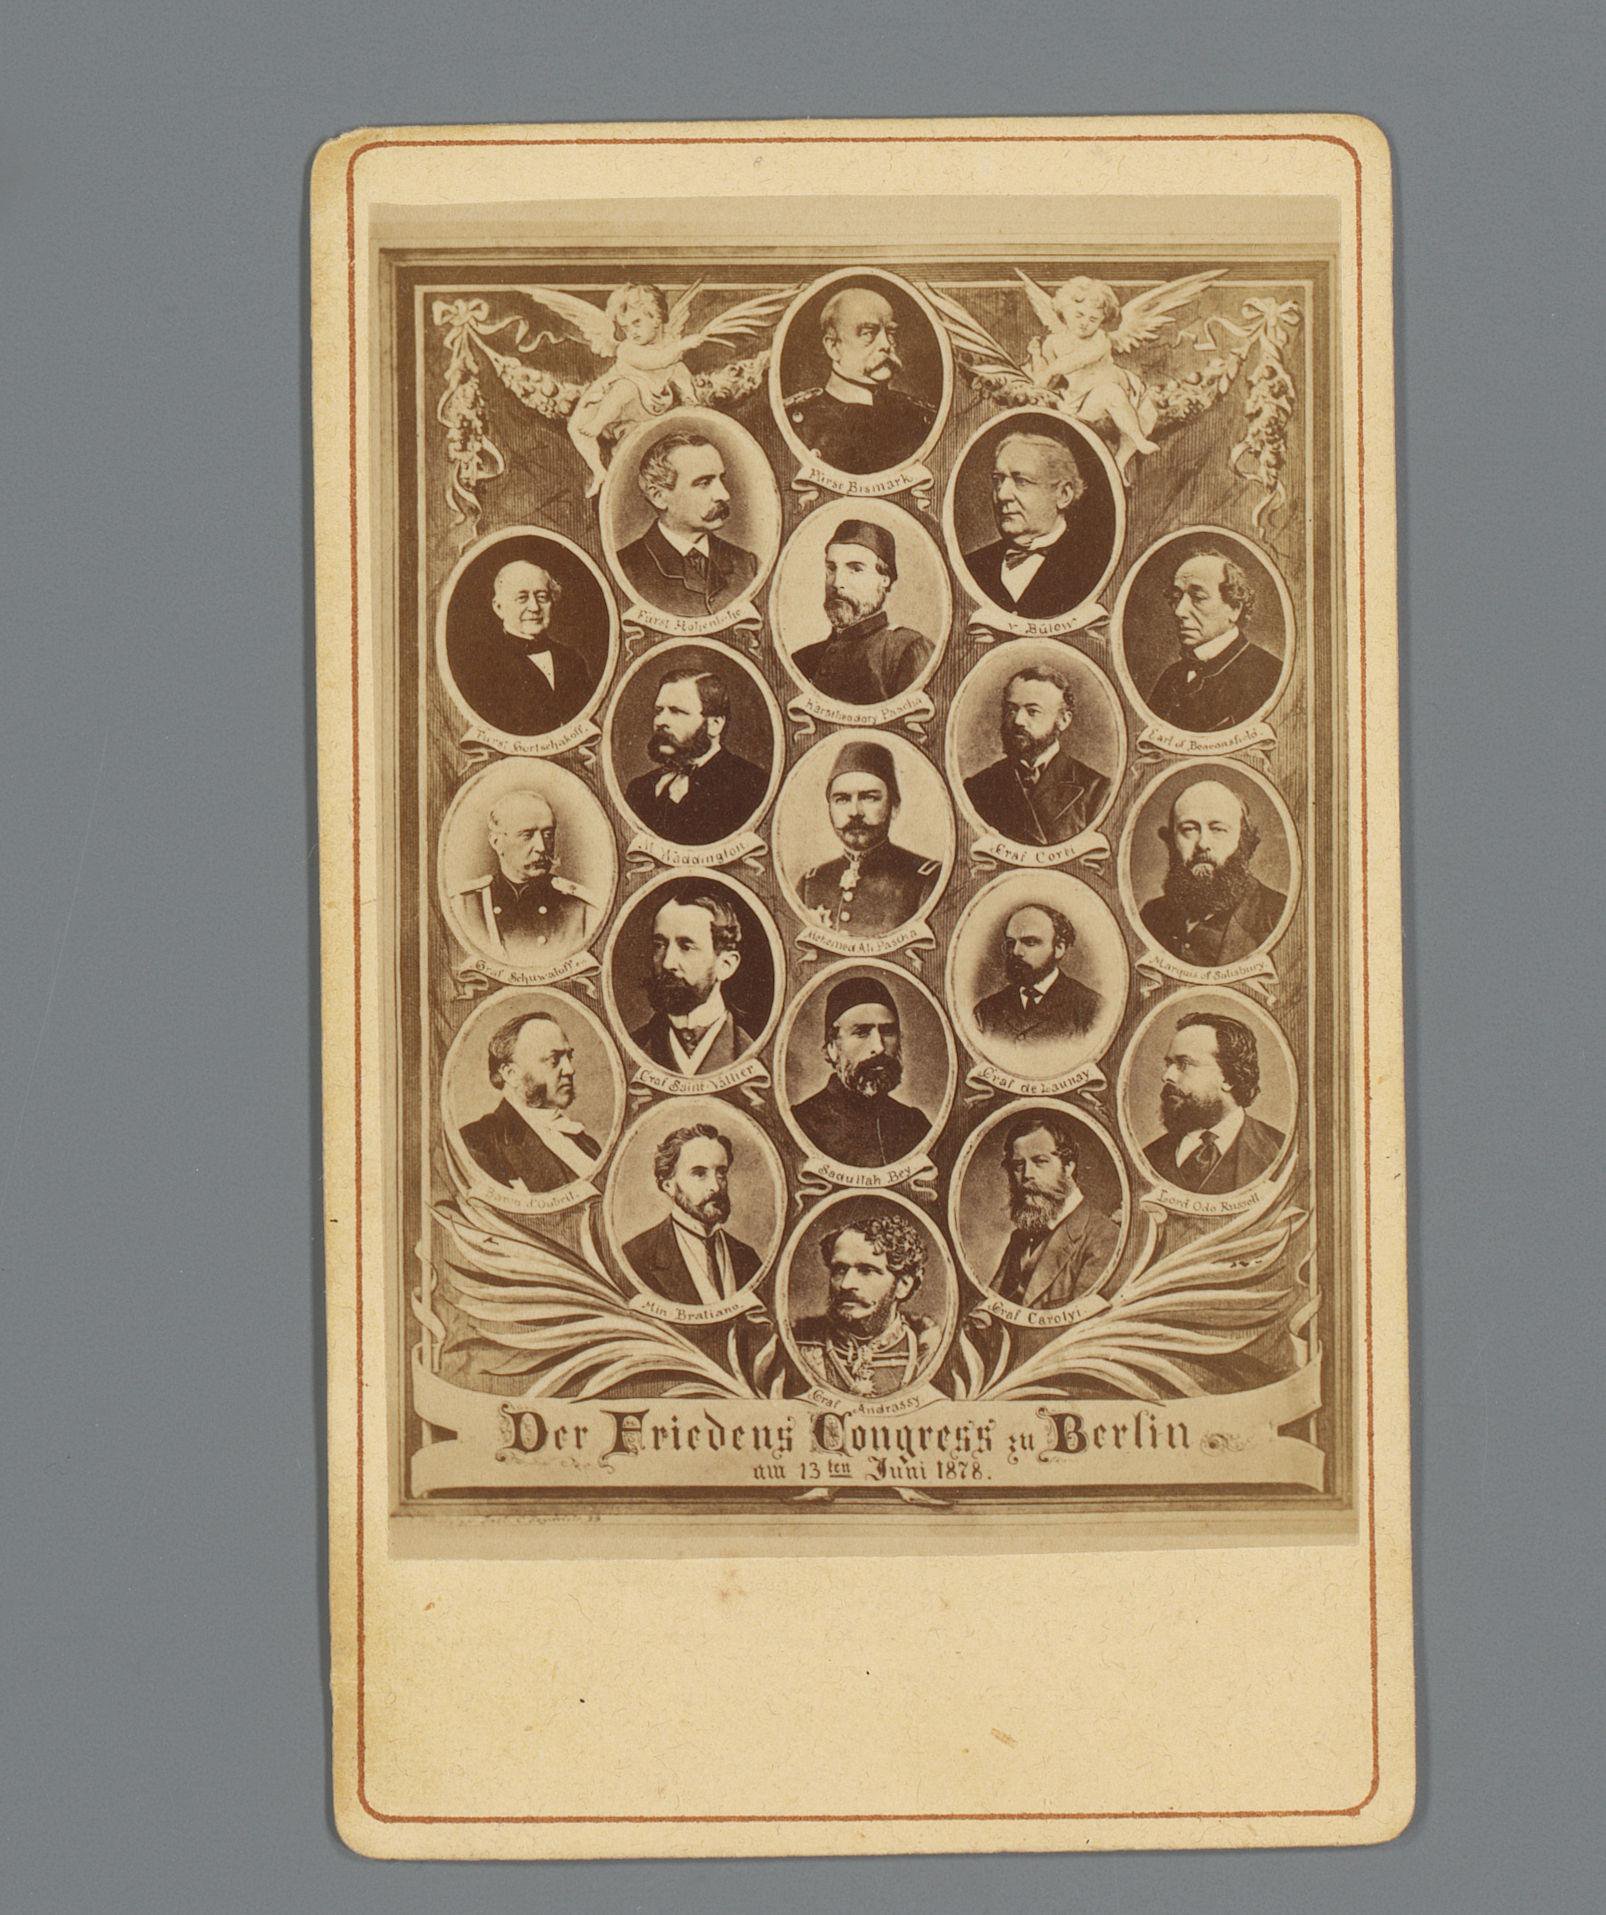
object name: carte de visite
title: Der Friedens Congress zu Berlin am 13ten Juni 1878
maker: Anonymous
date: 1878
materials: cardboard, paper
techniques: albumen print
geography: berlin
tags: politician, e.g. party leader, berlin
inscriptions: inscription: ‘Fridskongressen i Berlin’